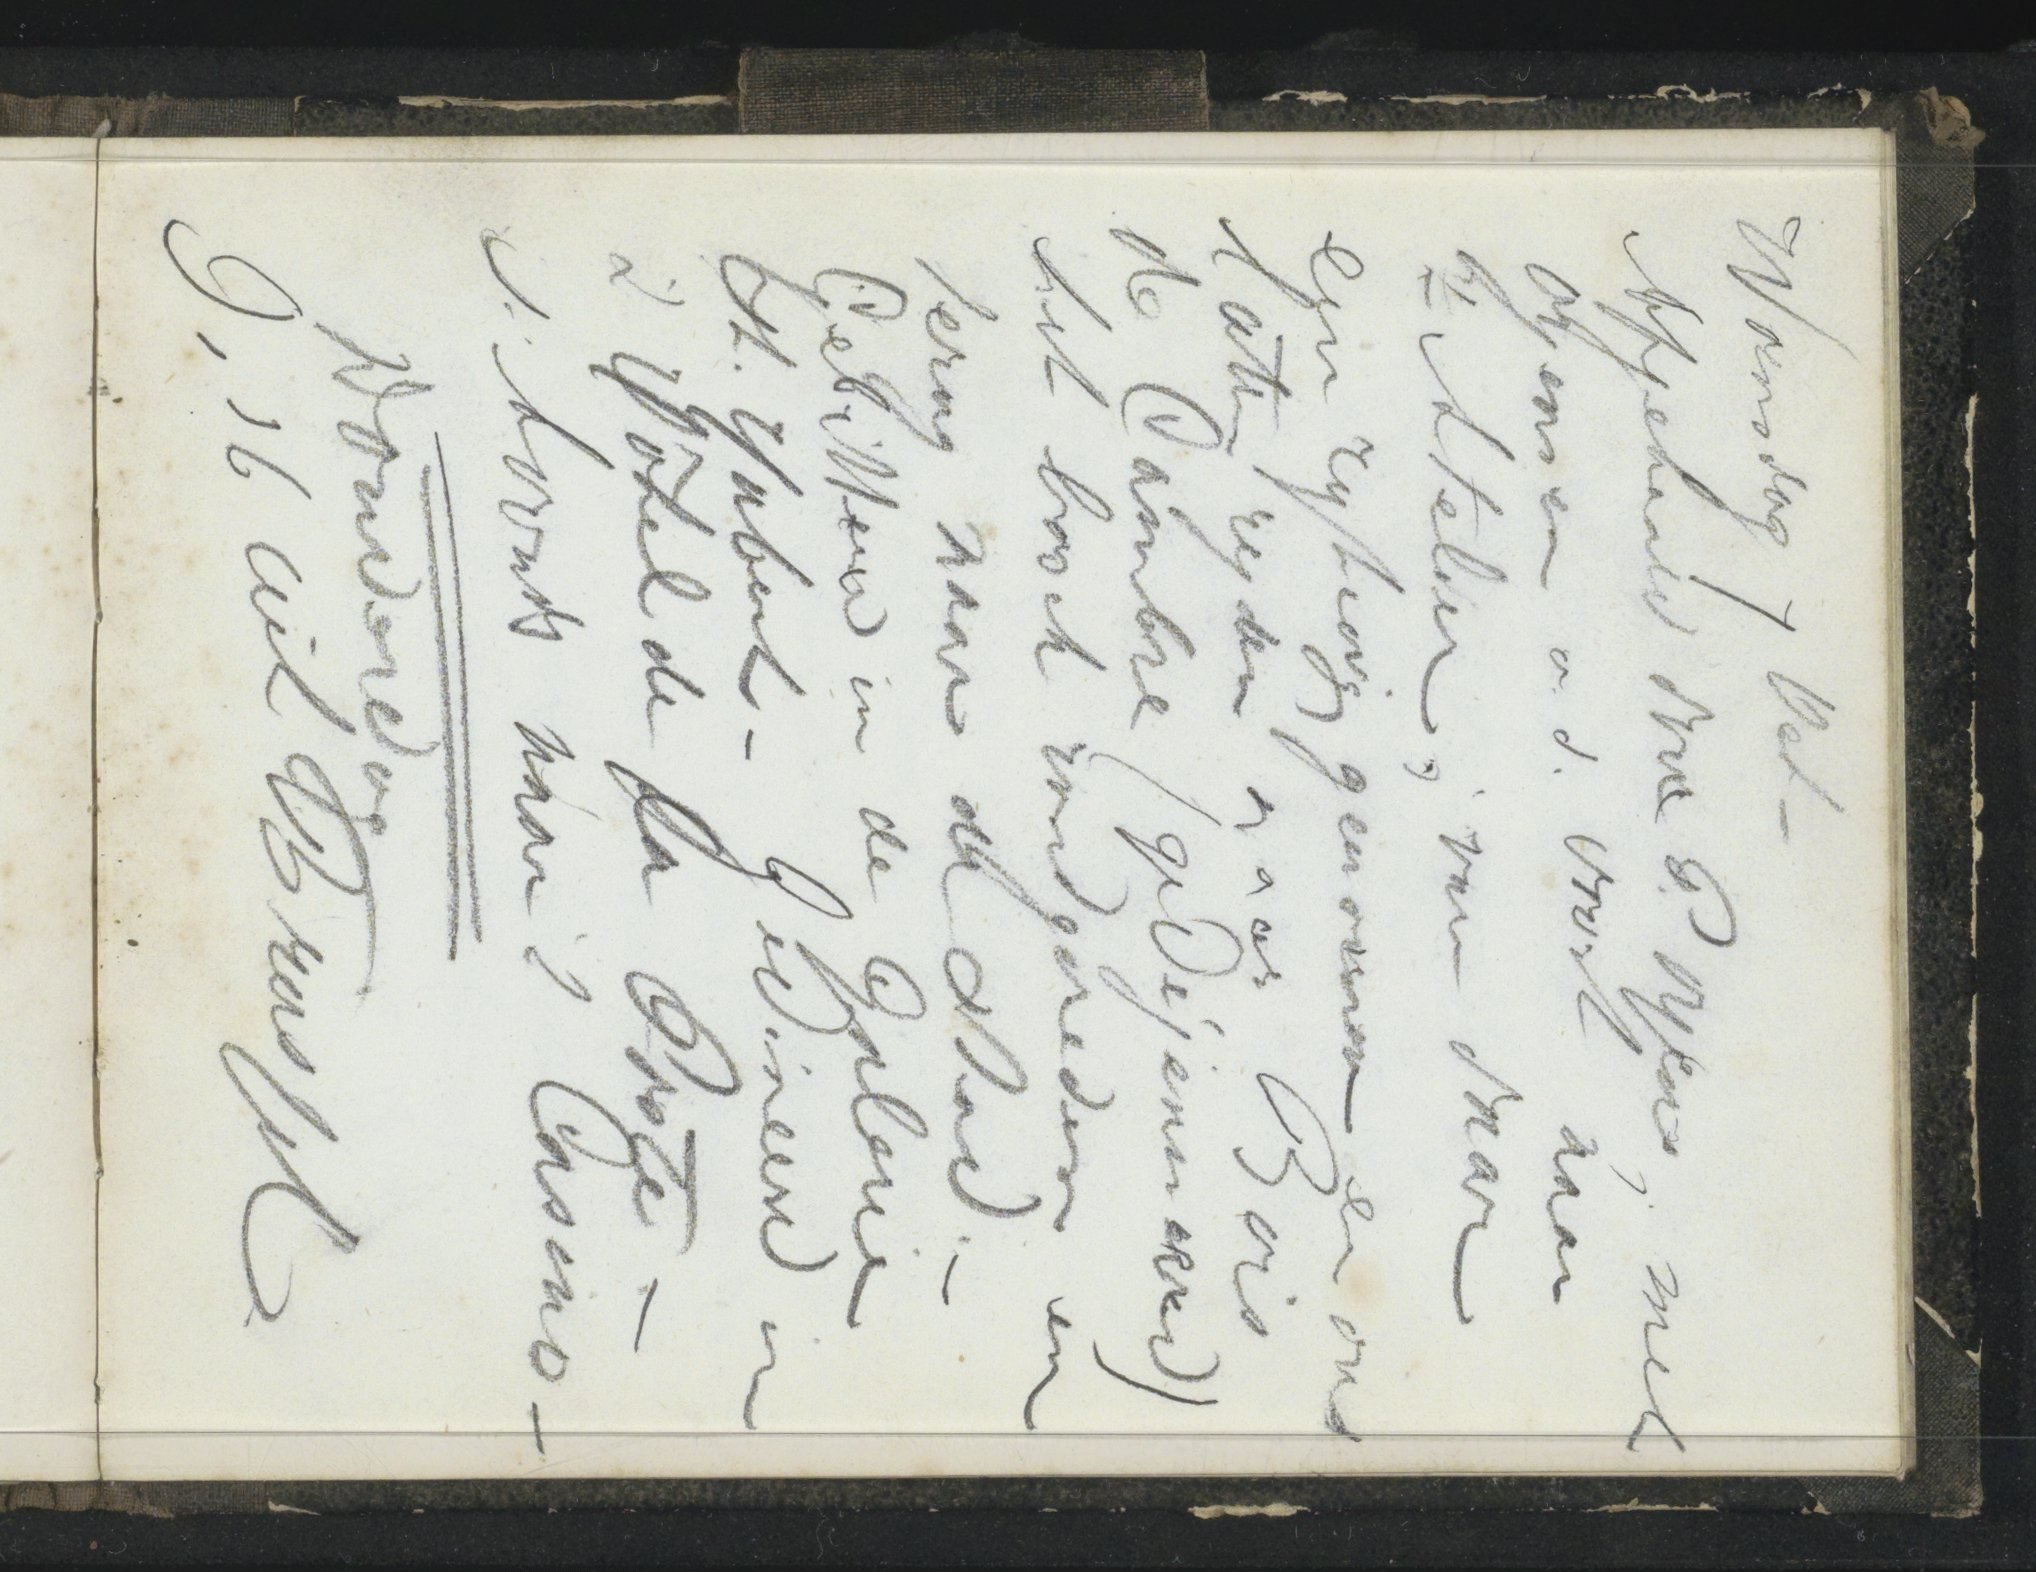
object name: sketchbook leaf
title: Notities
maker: theo hanrath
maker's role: draughtsman, painter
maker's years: 1853-1883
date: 1879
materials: paper, pencil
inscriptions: date and inscription: ‘Woensdag 7 Oct. [...]’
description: Blad 24 recto uit een schetsboek met 27 bladen.